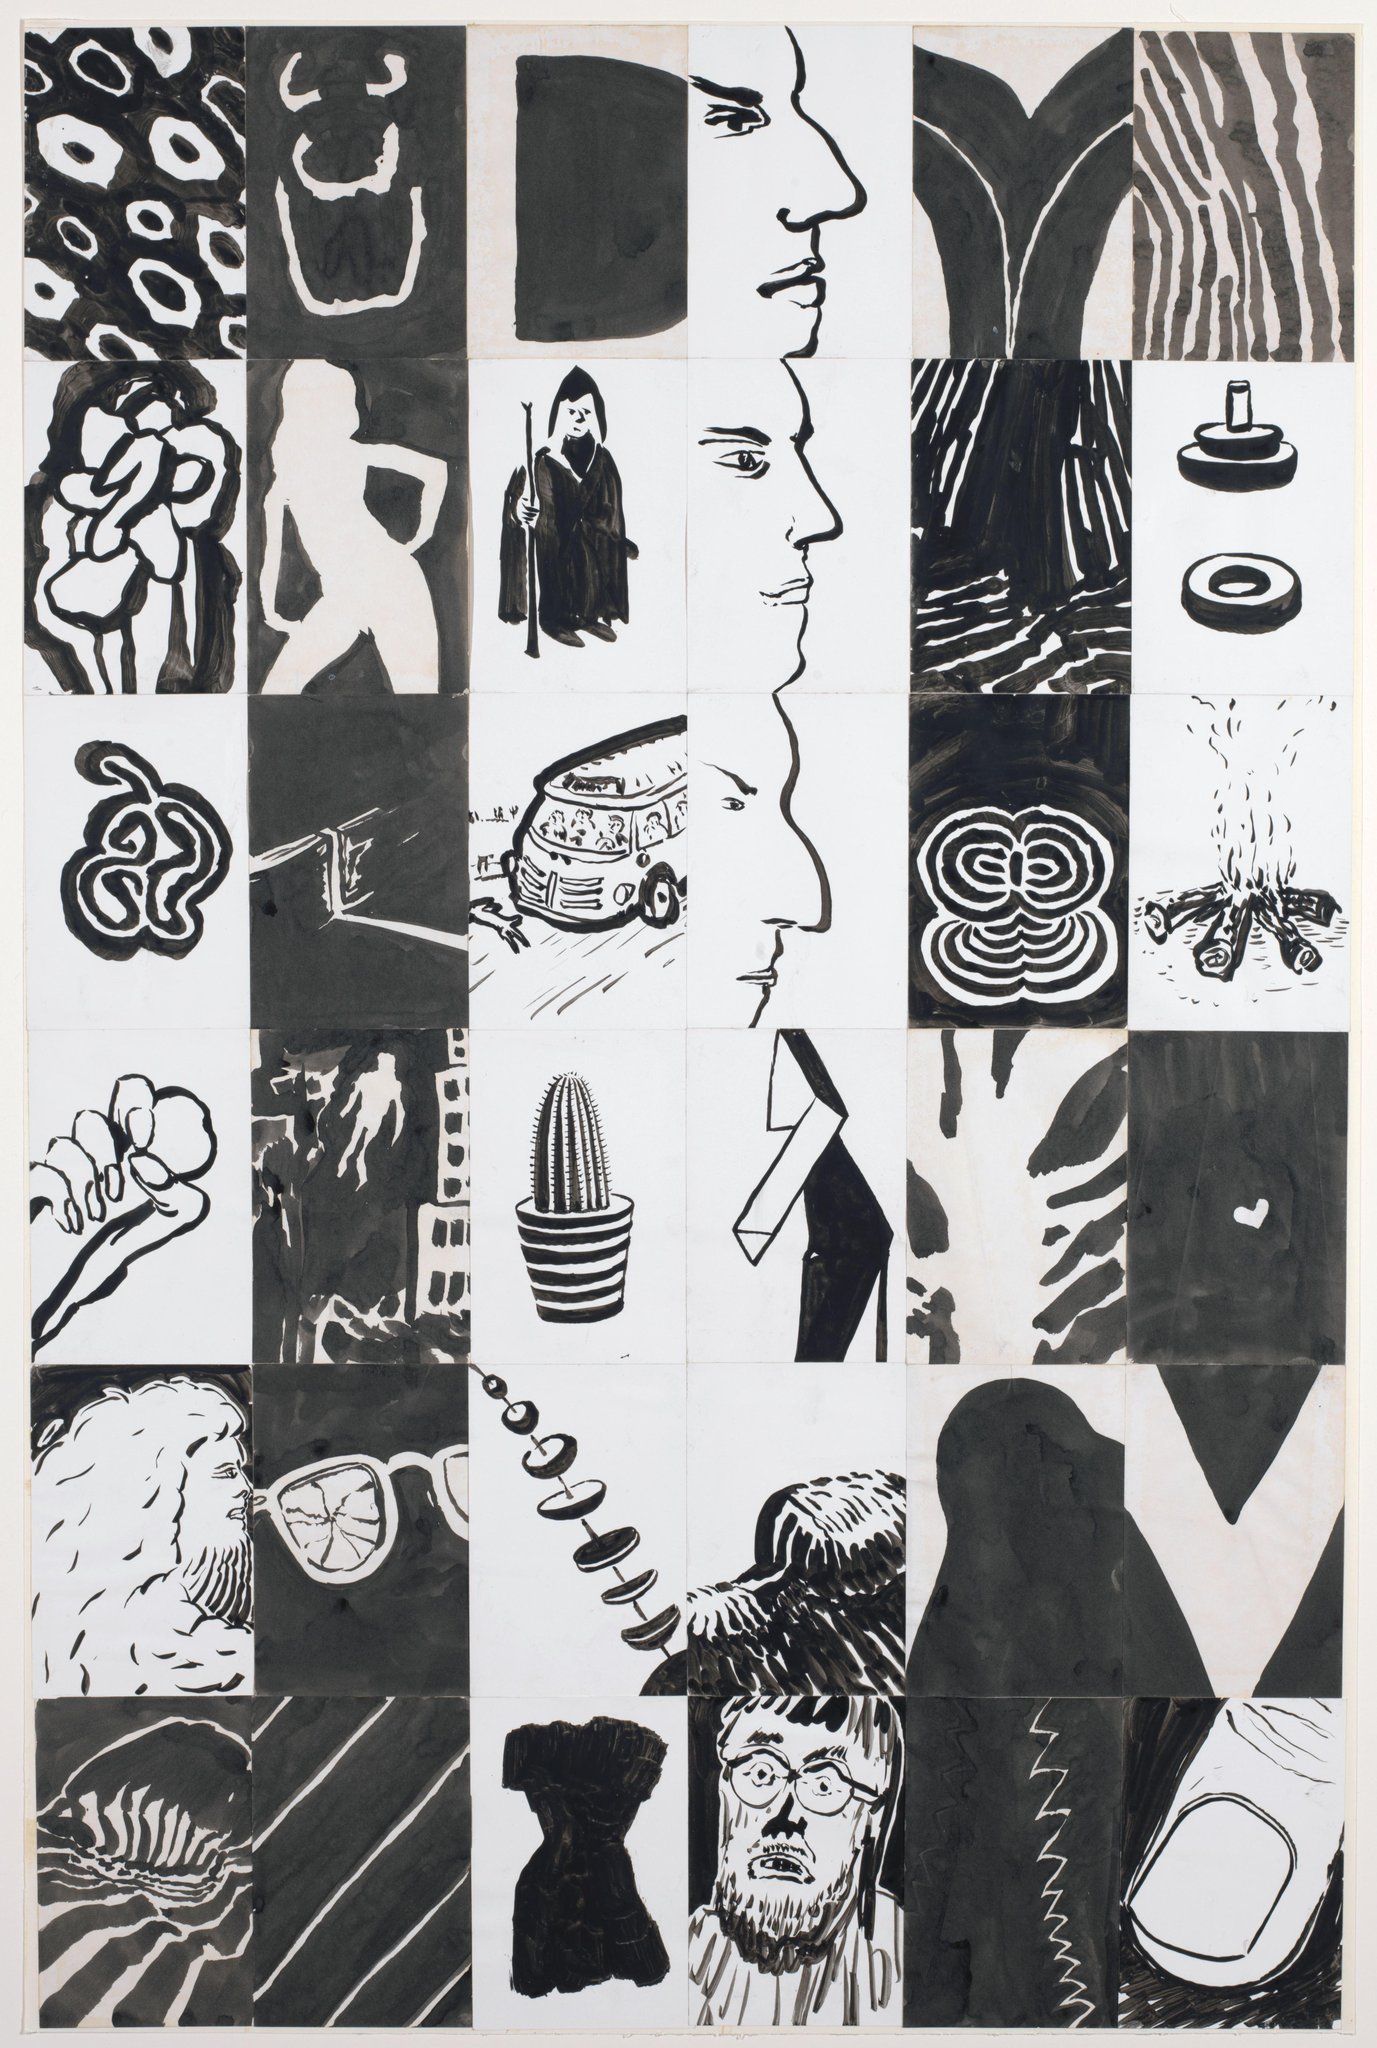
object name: drawing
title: The Waterfall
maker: pieter holstein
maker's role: draughtsman, painter, print maker, sculptor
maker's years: 1934-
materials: ink, paper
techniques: brush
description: 36 voorstellingen binnen vierkanten, waaronder een cactus, gebroken bril en houtvuur.